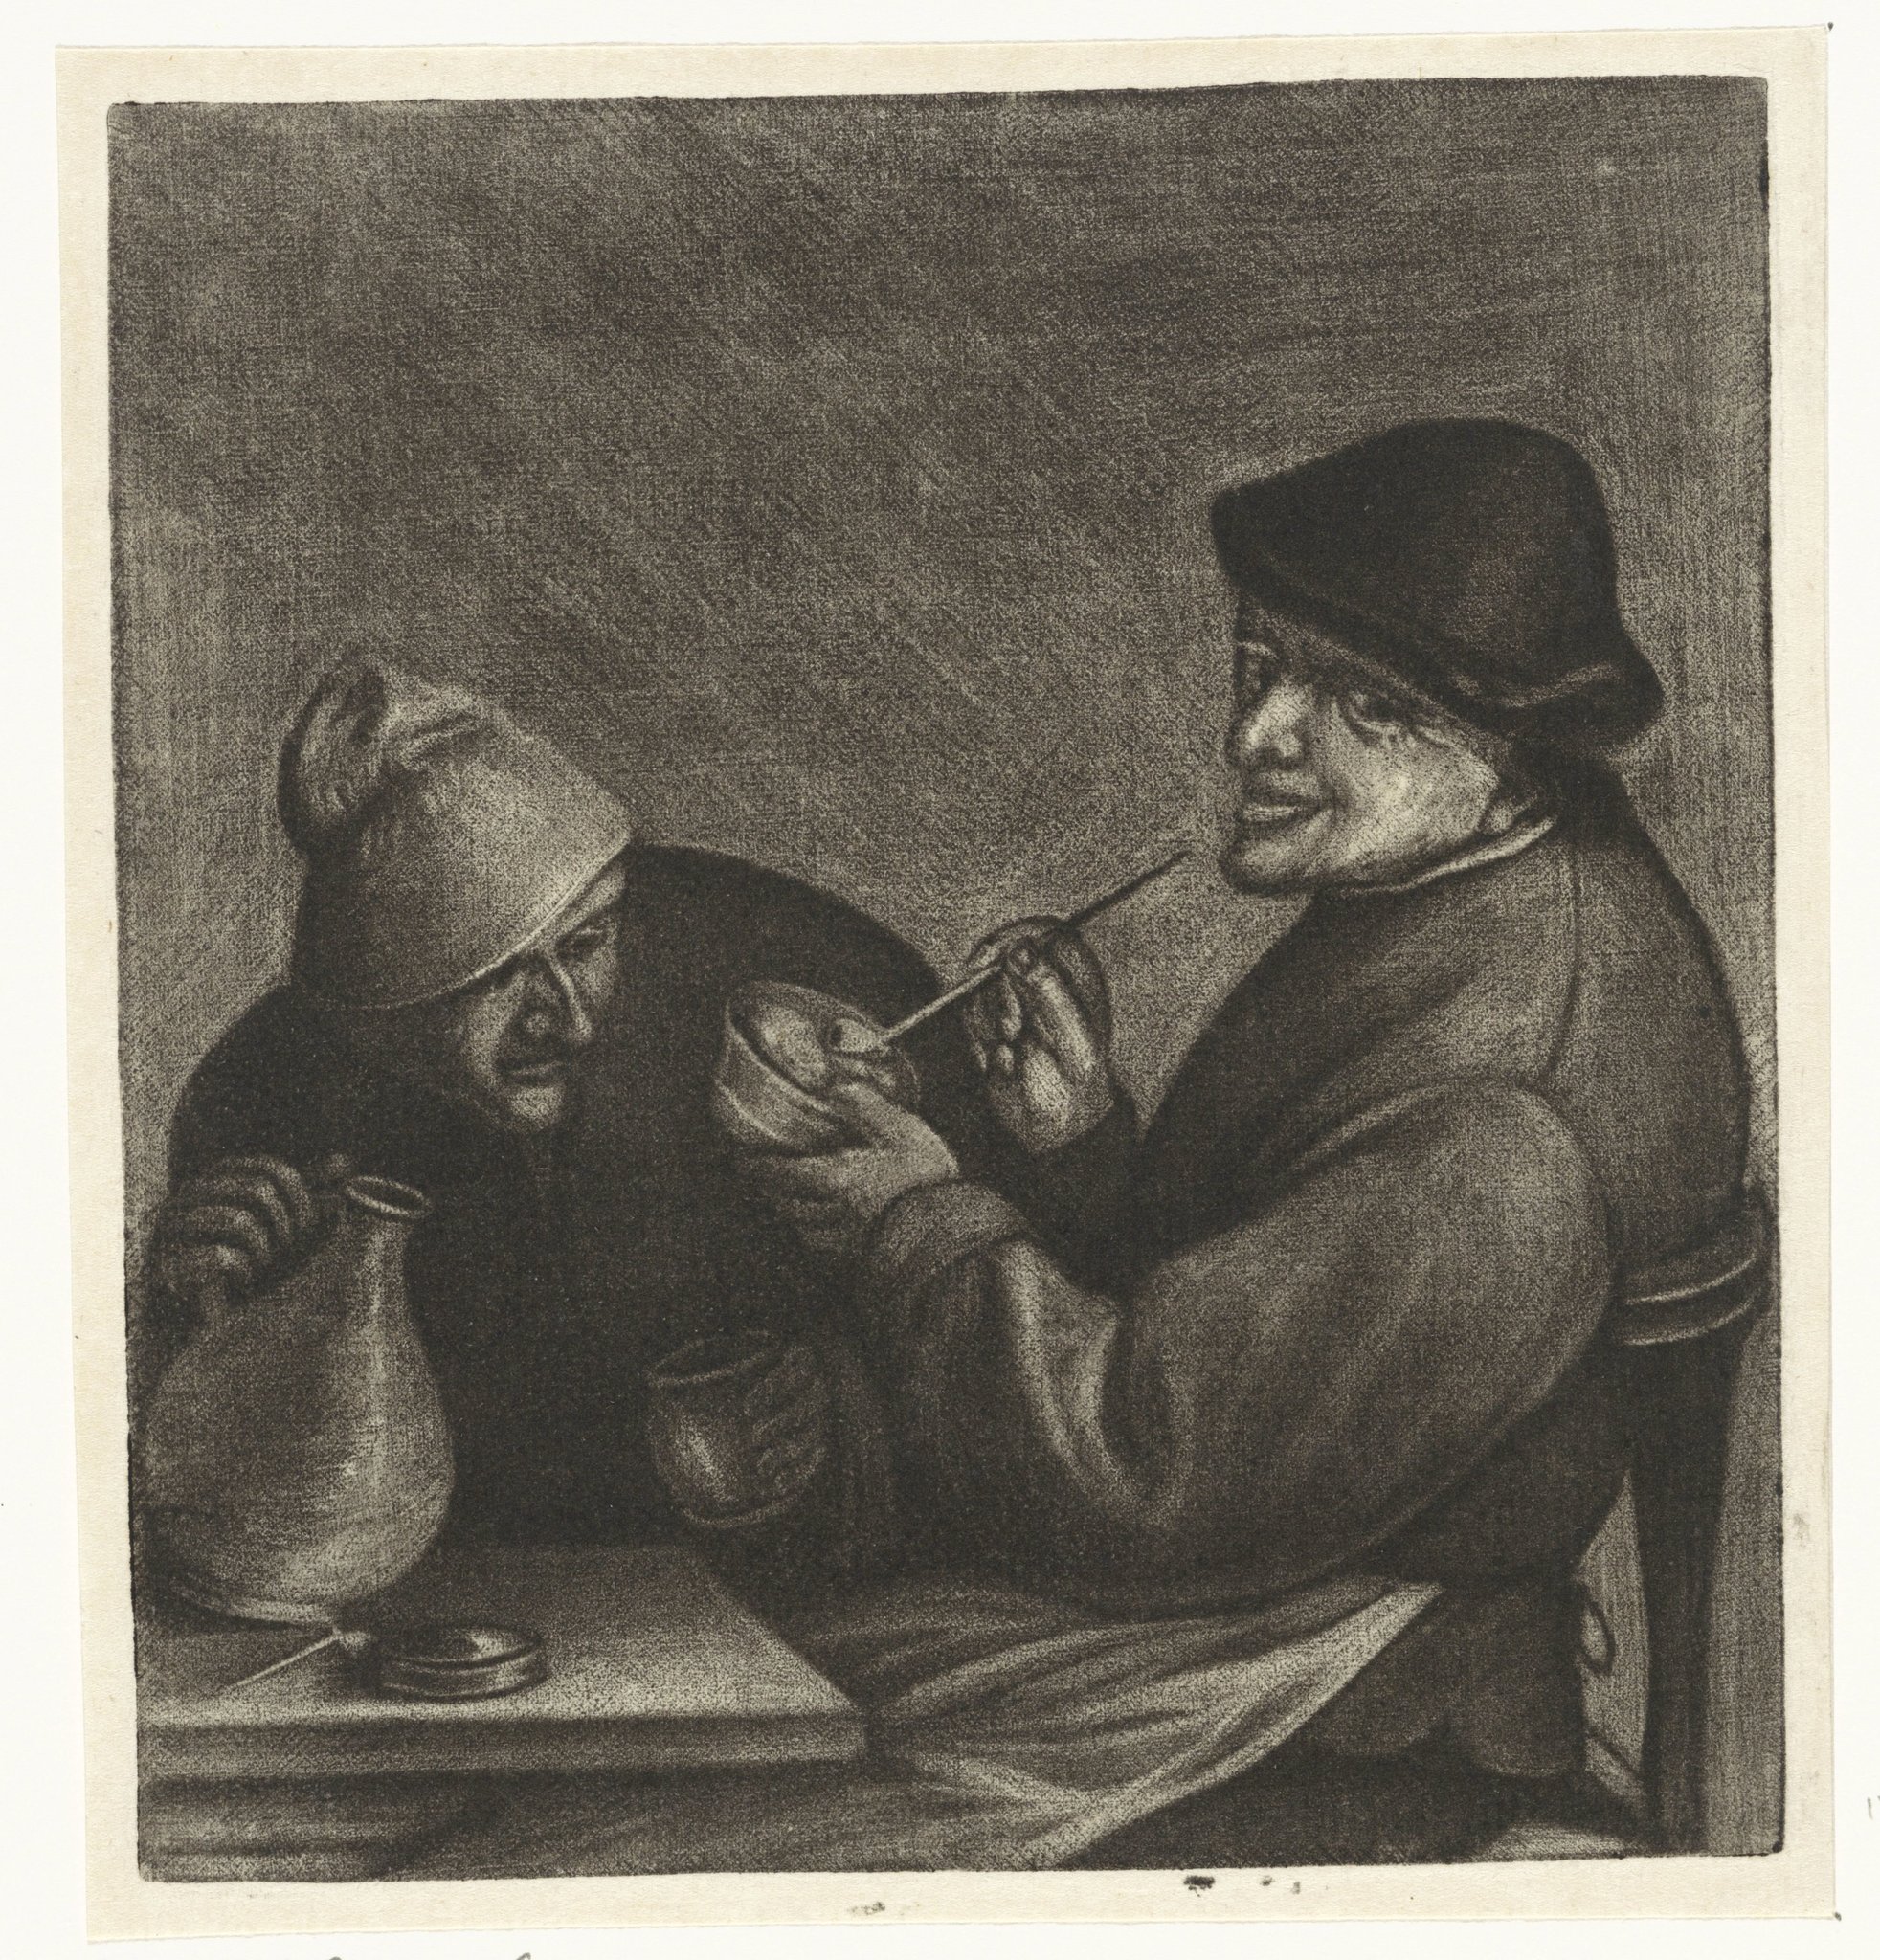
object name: print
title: Roker en drinker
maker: jacob hoolaart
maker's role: print maker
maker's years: 1713-1789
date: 1723-1789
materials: paper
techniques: mezzotint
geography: dordrecht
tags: pipe ~ tobacco, drinking-vessels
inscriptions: collector's mark: Lugt 2228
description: Aan een tafel zitten twee mannen waarvan er een zijn pijp aansteekt. De ander schenkt zijn glas vol. Ze dragen beiden een muts.